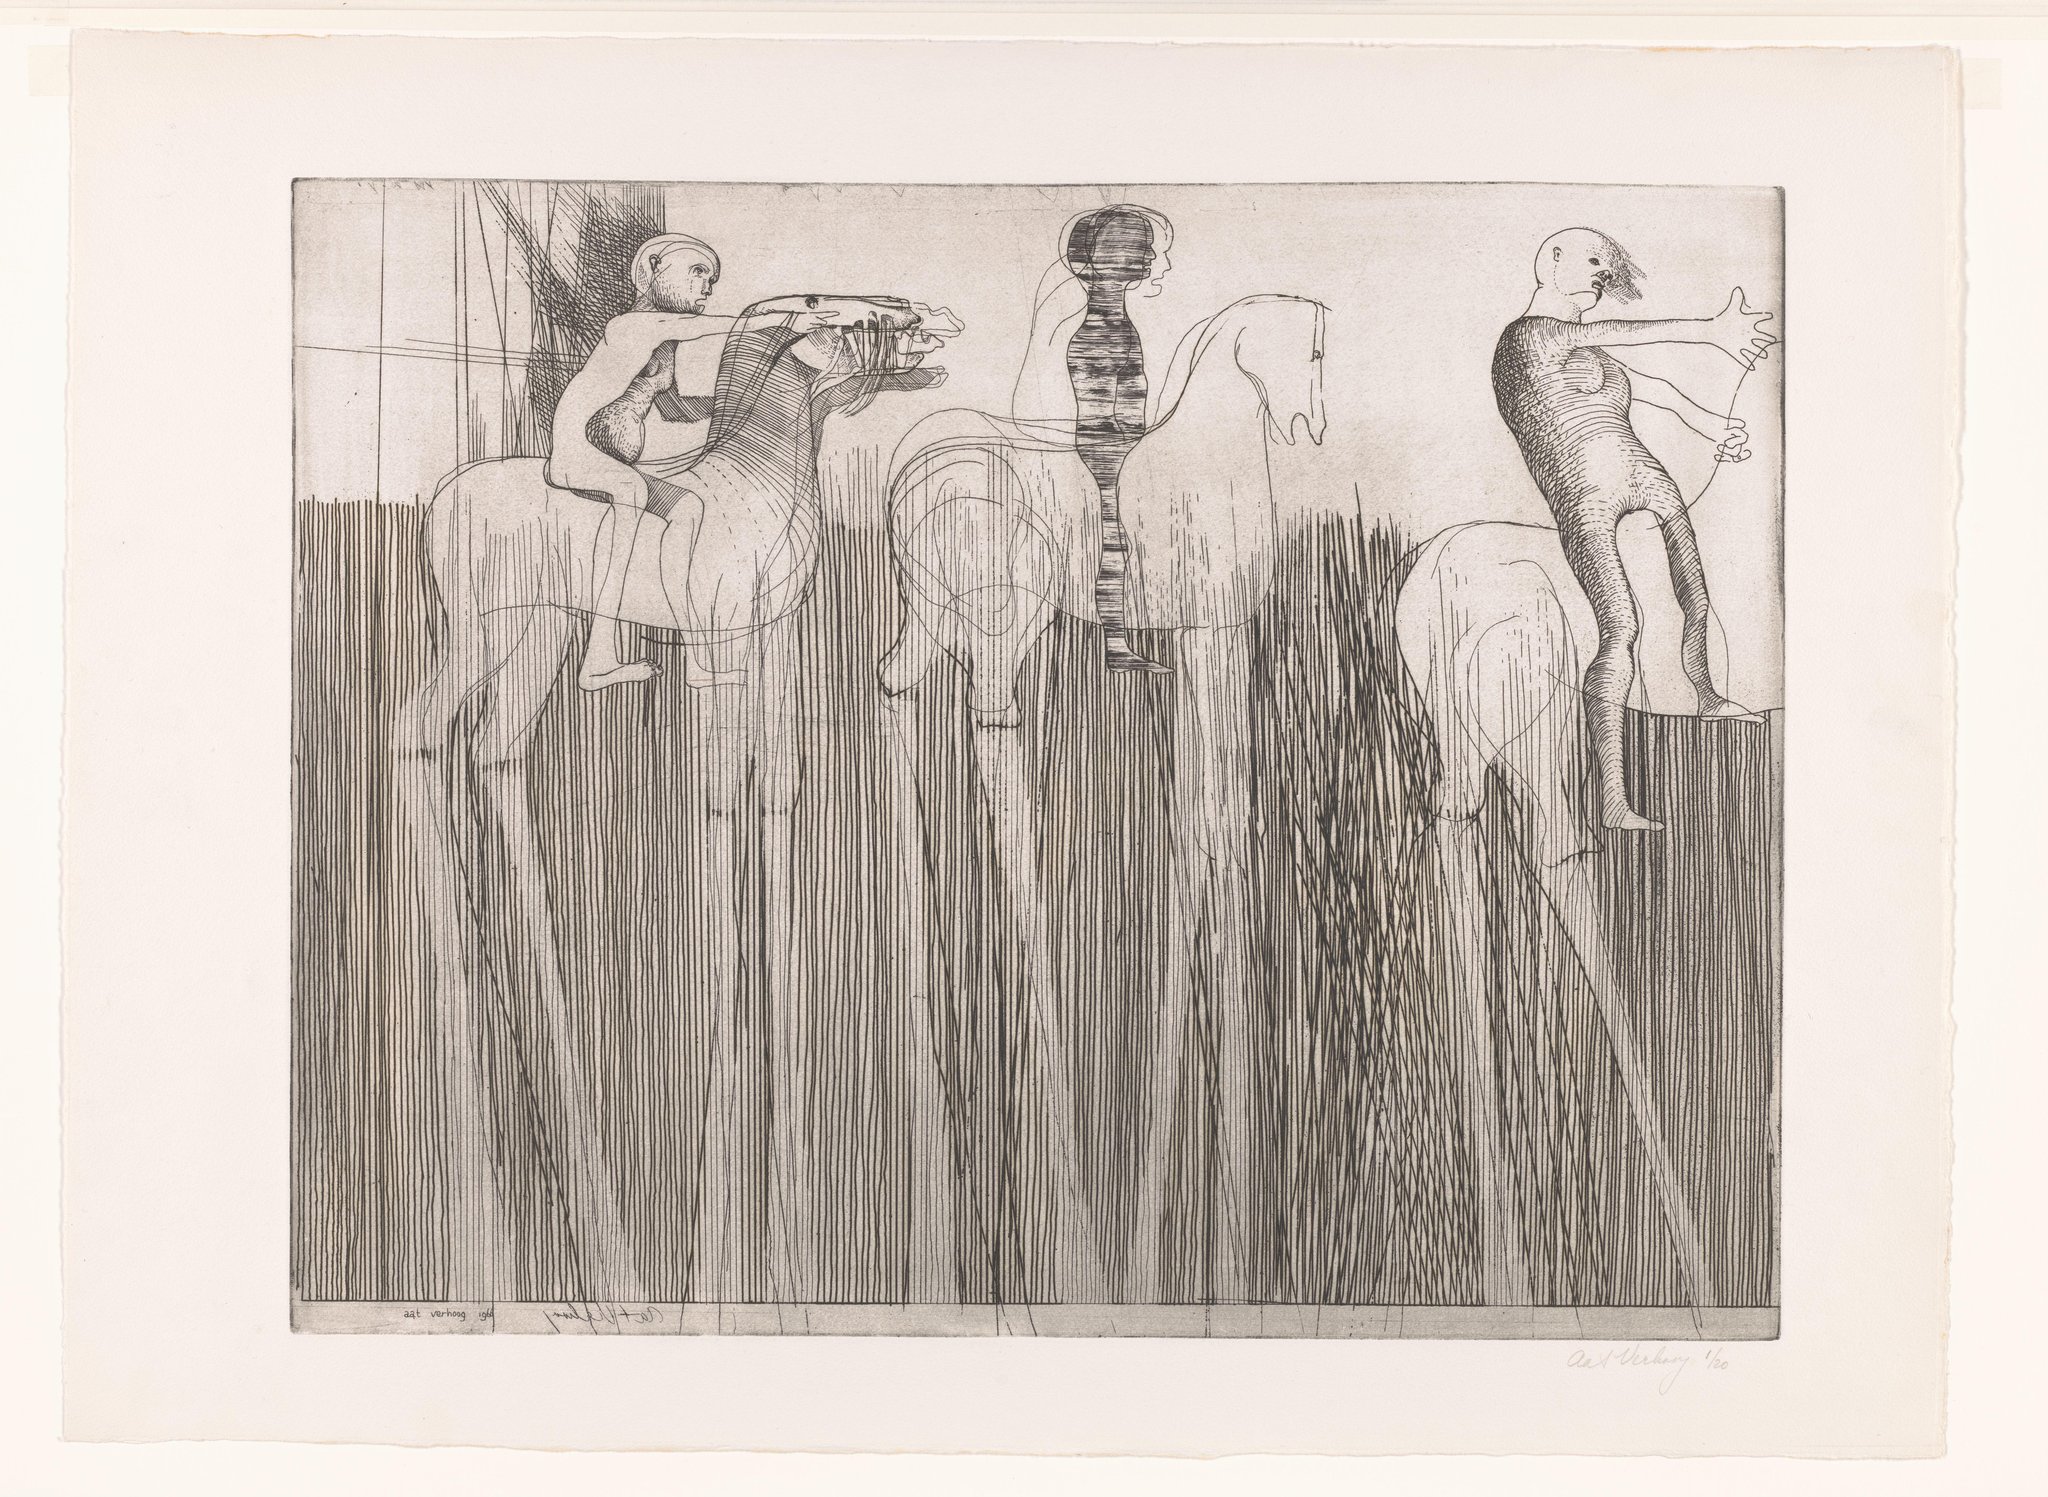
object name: print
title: Paarden en ruiters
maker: aat verhoog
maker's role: print maker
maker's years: 1933-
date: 1966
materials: paper, ink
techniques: aquatint, etching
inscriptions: edition: ‘1/20’, signature and date: ‘aat verhoog 1966’, signature: ‘Aat Verhoog’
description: De huidige titel is door het Rijksmuseum overgenomen van het Instituut Collectie Nederland.